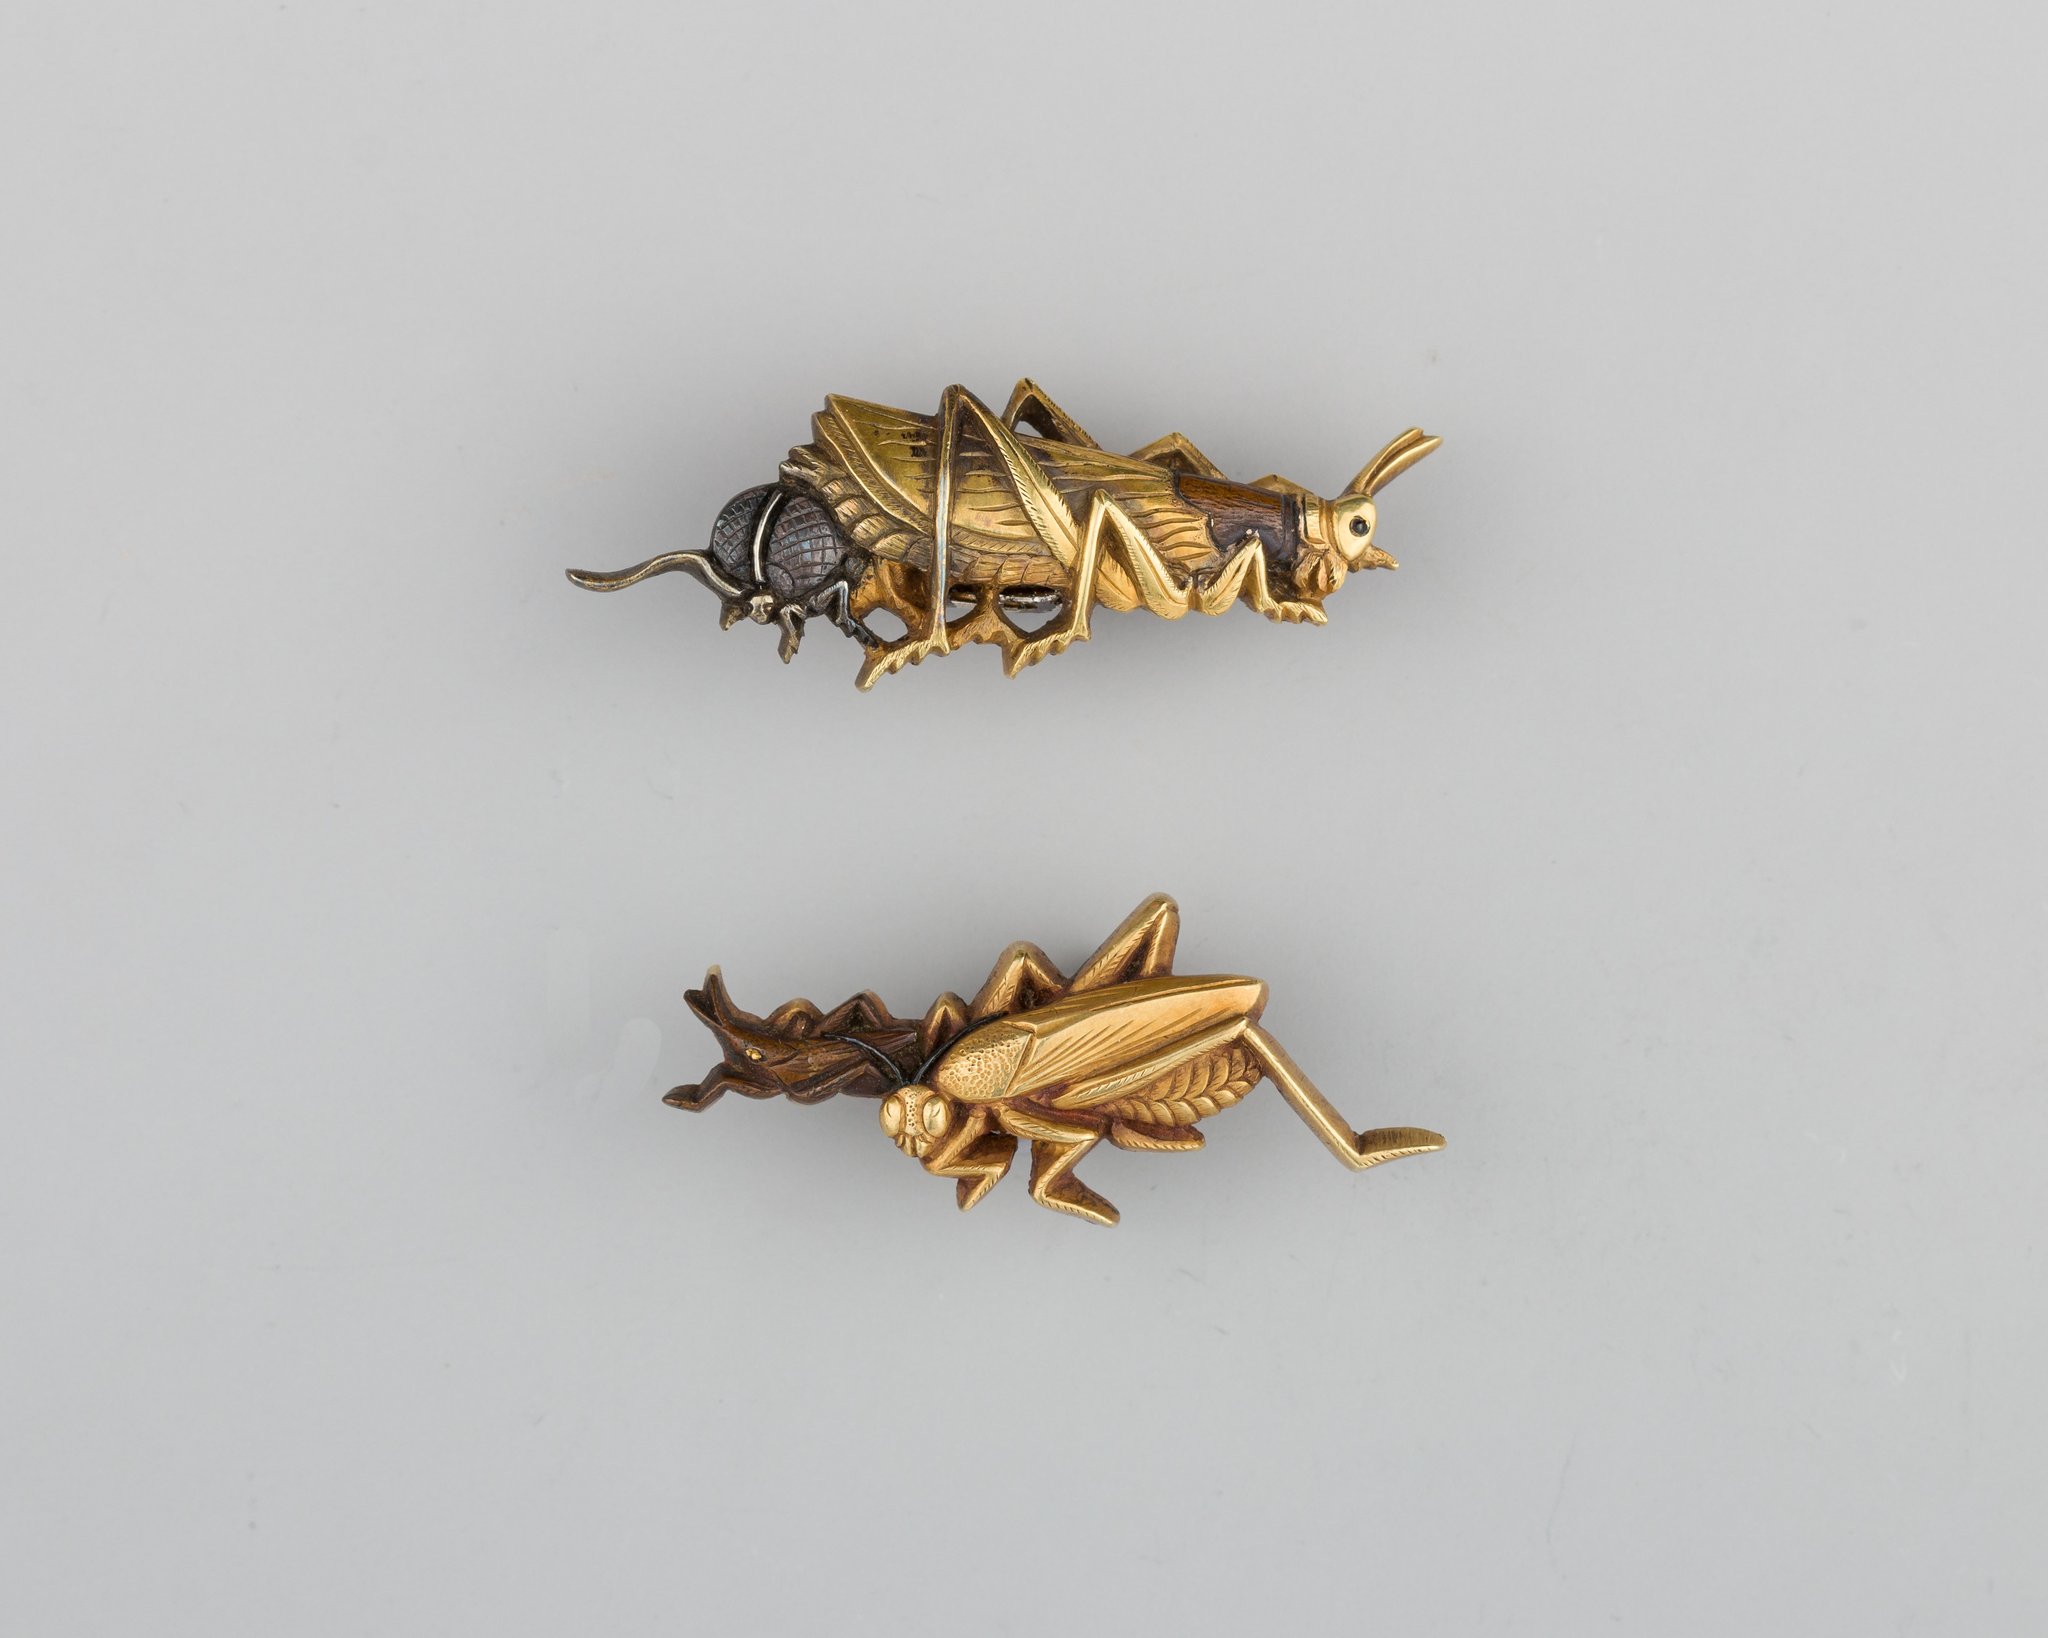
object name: pair of sword grip ornament menuki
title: Pair of Sword-Grip Ornaments (Menuki)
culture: japanese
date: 1701-1800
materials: copper, gold alloy, gold, silver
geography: japan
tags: insects